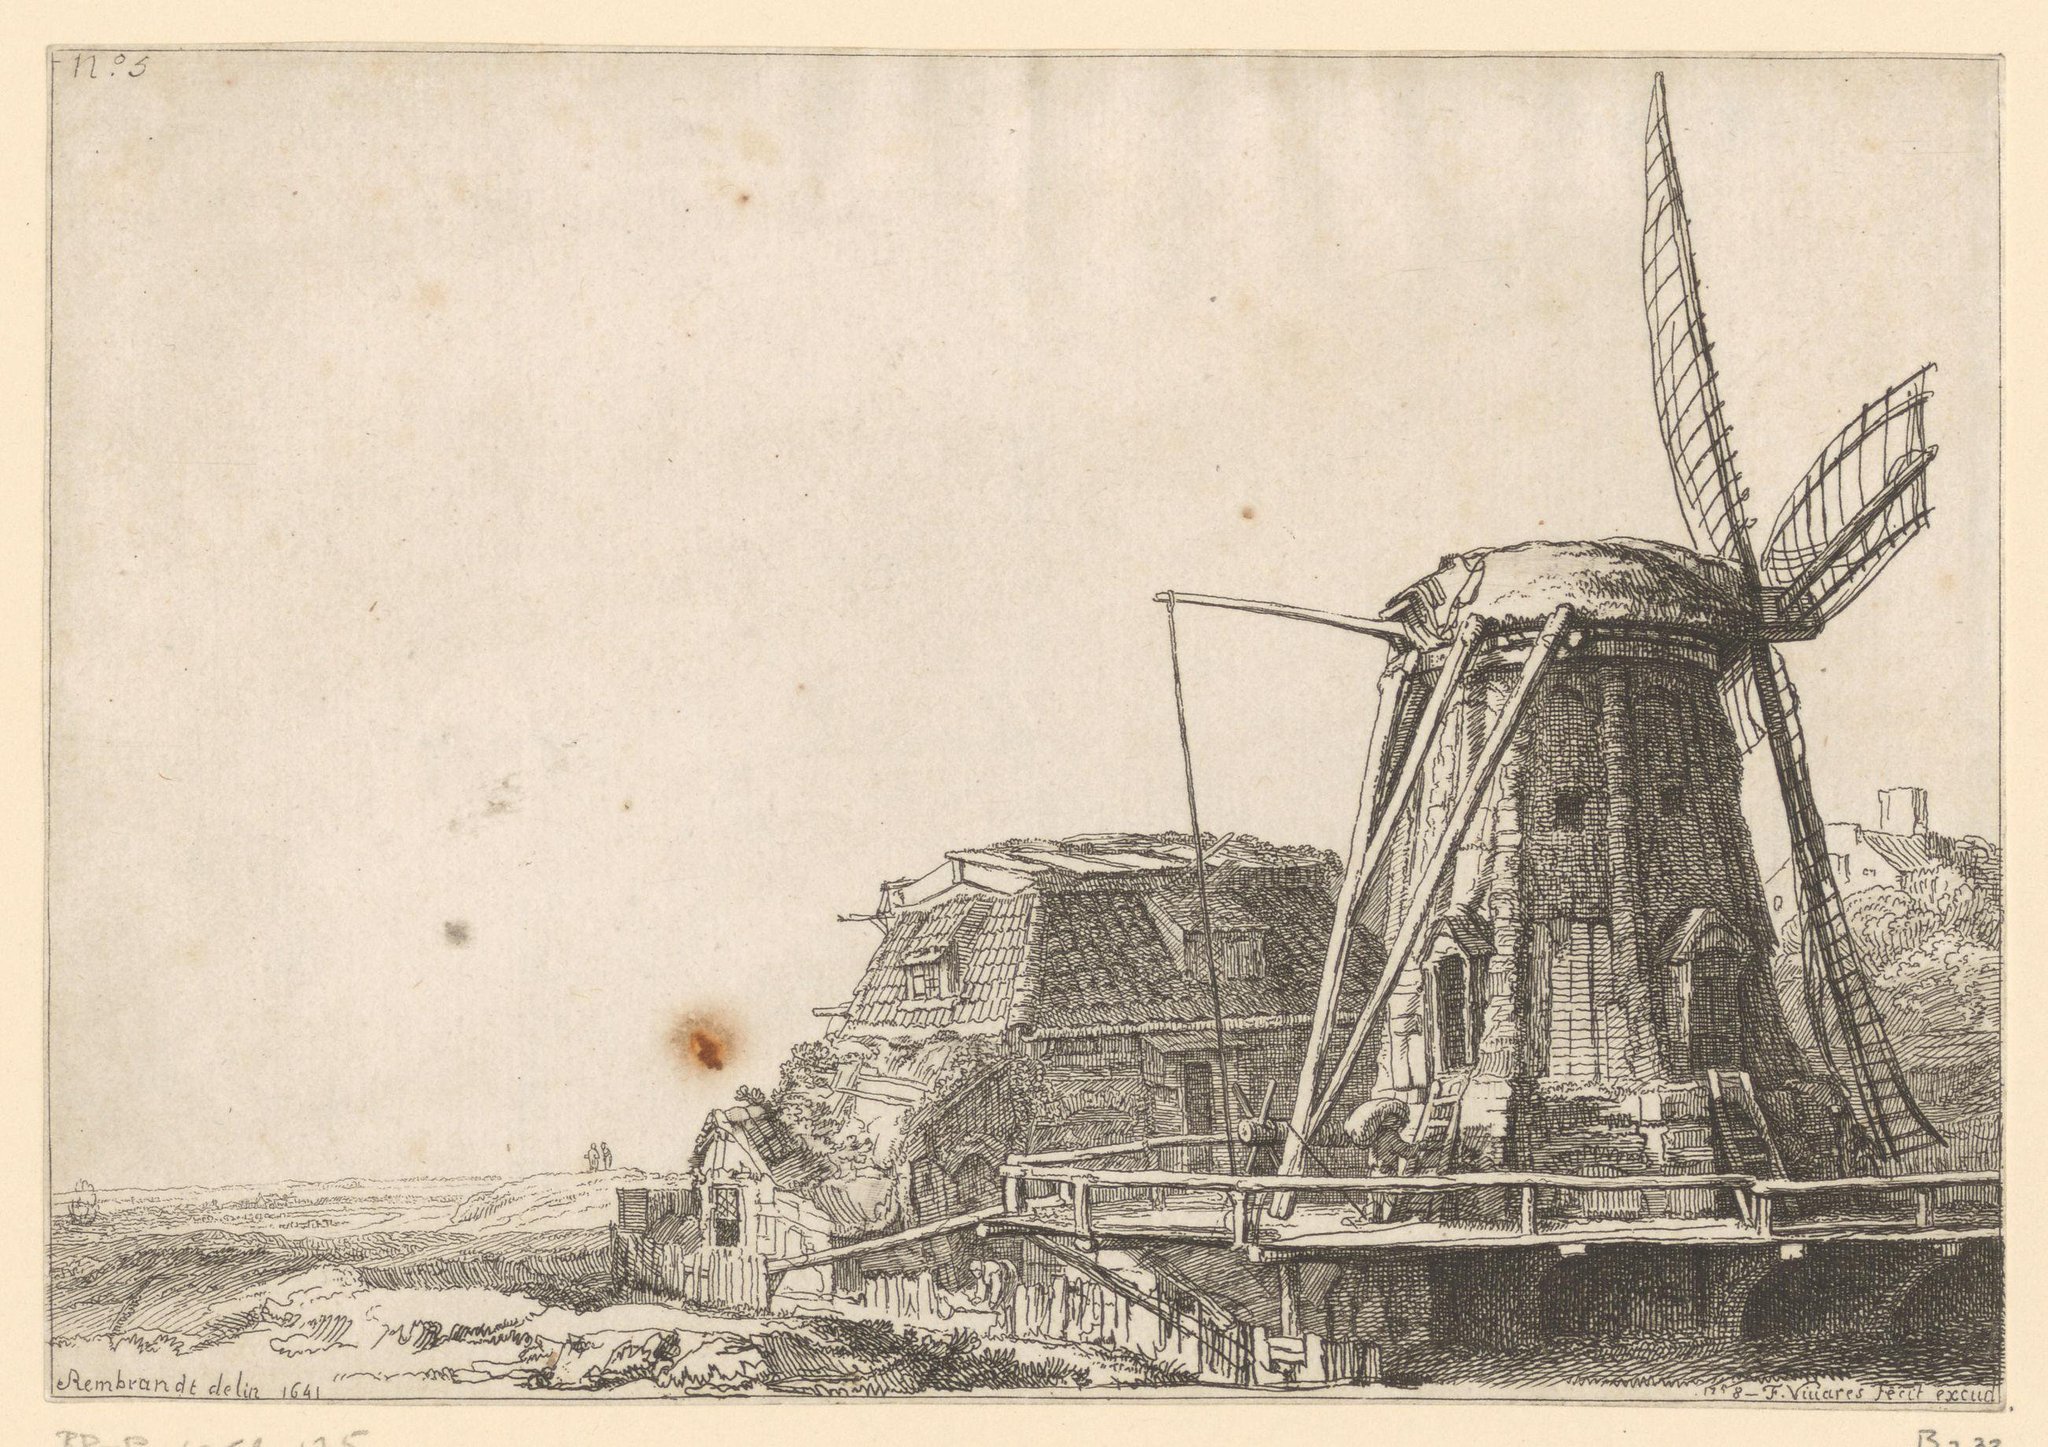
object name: print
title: The windmill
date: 1641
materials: paper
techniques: etching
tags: windmill in landscape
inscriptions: collector's mark: Lugt 2228, collector's mark: Lugt 2760